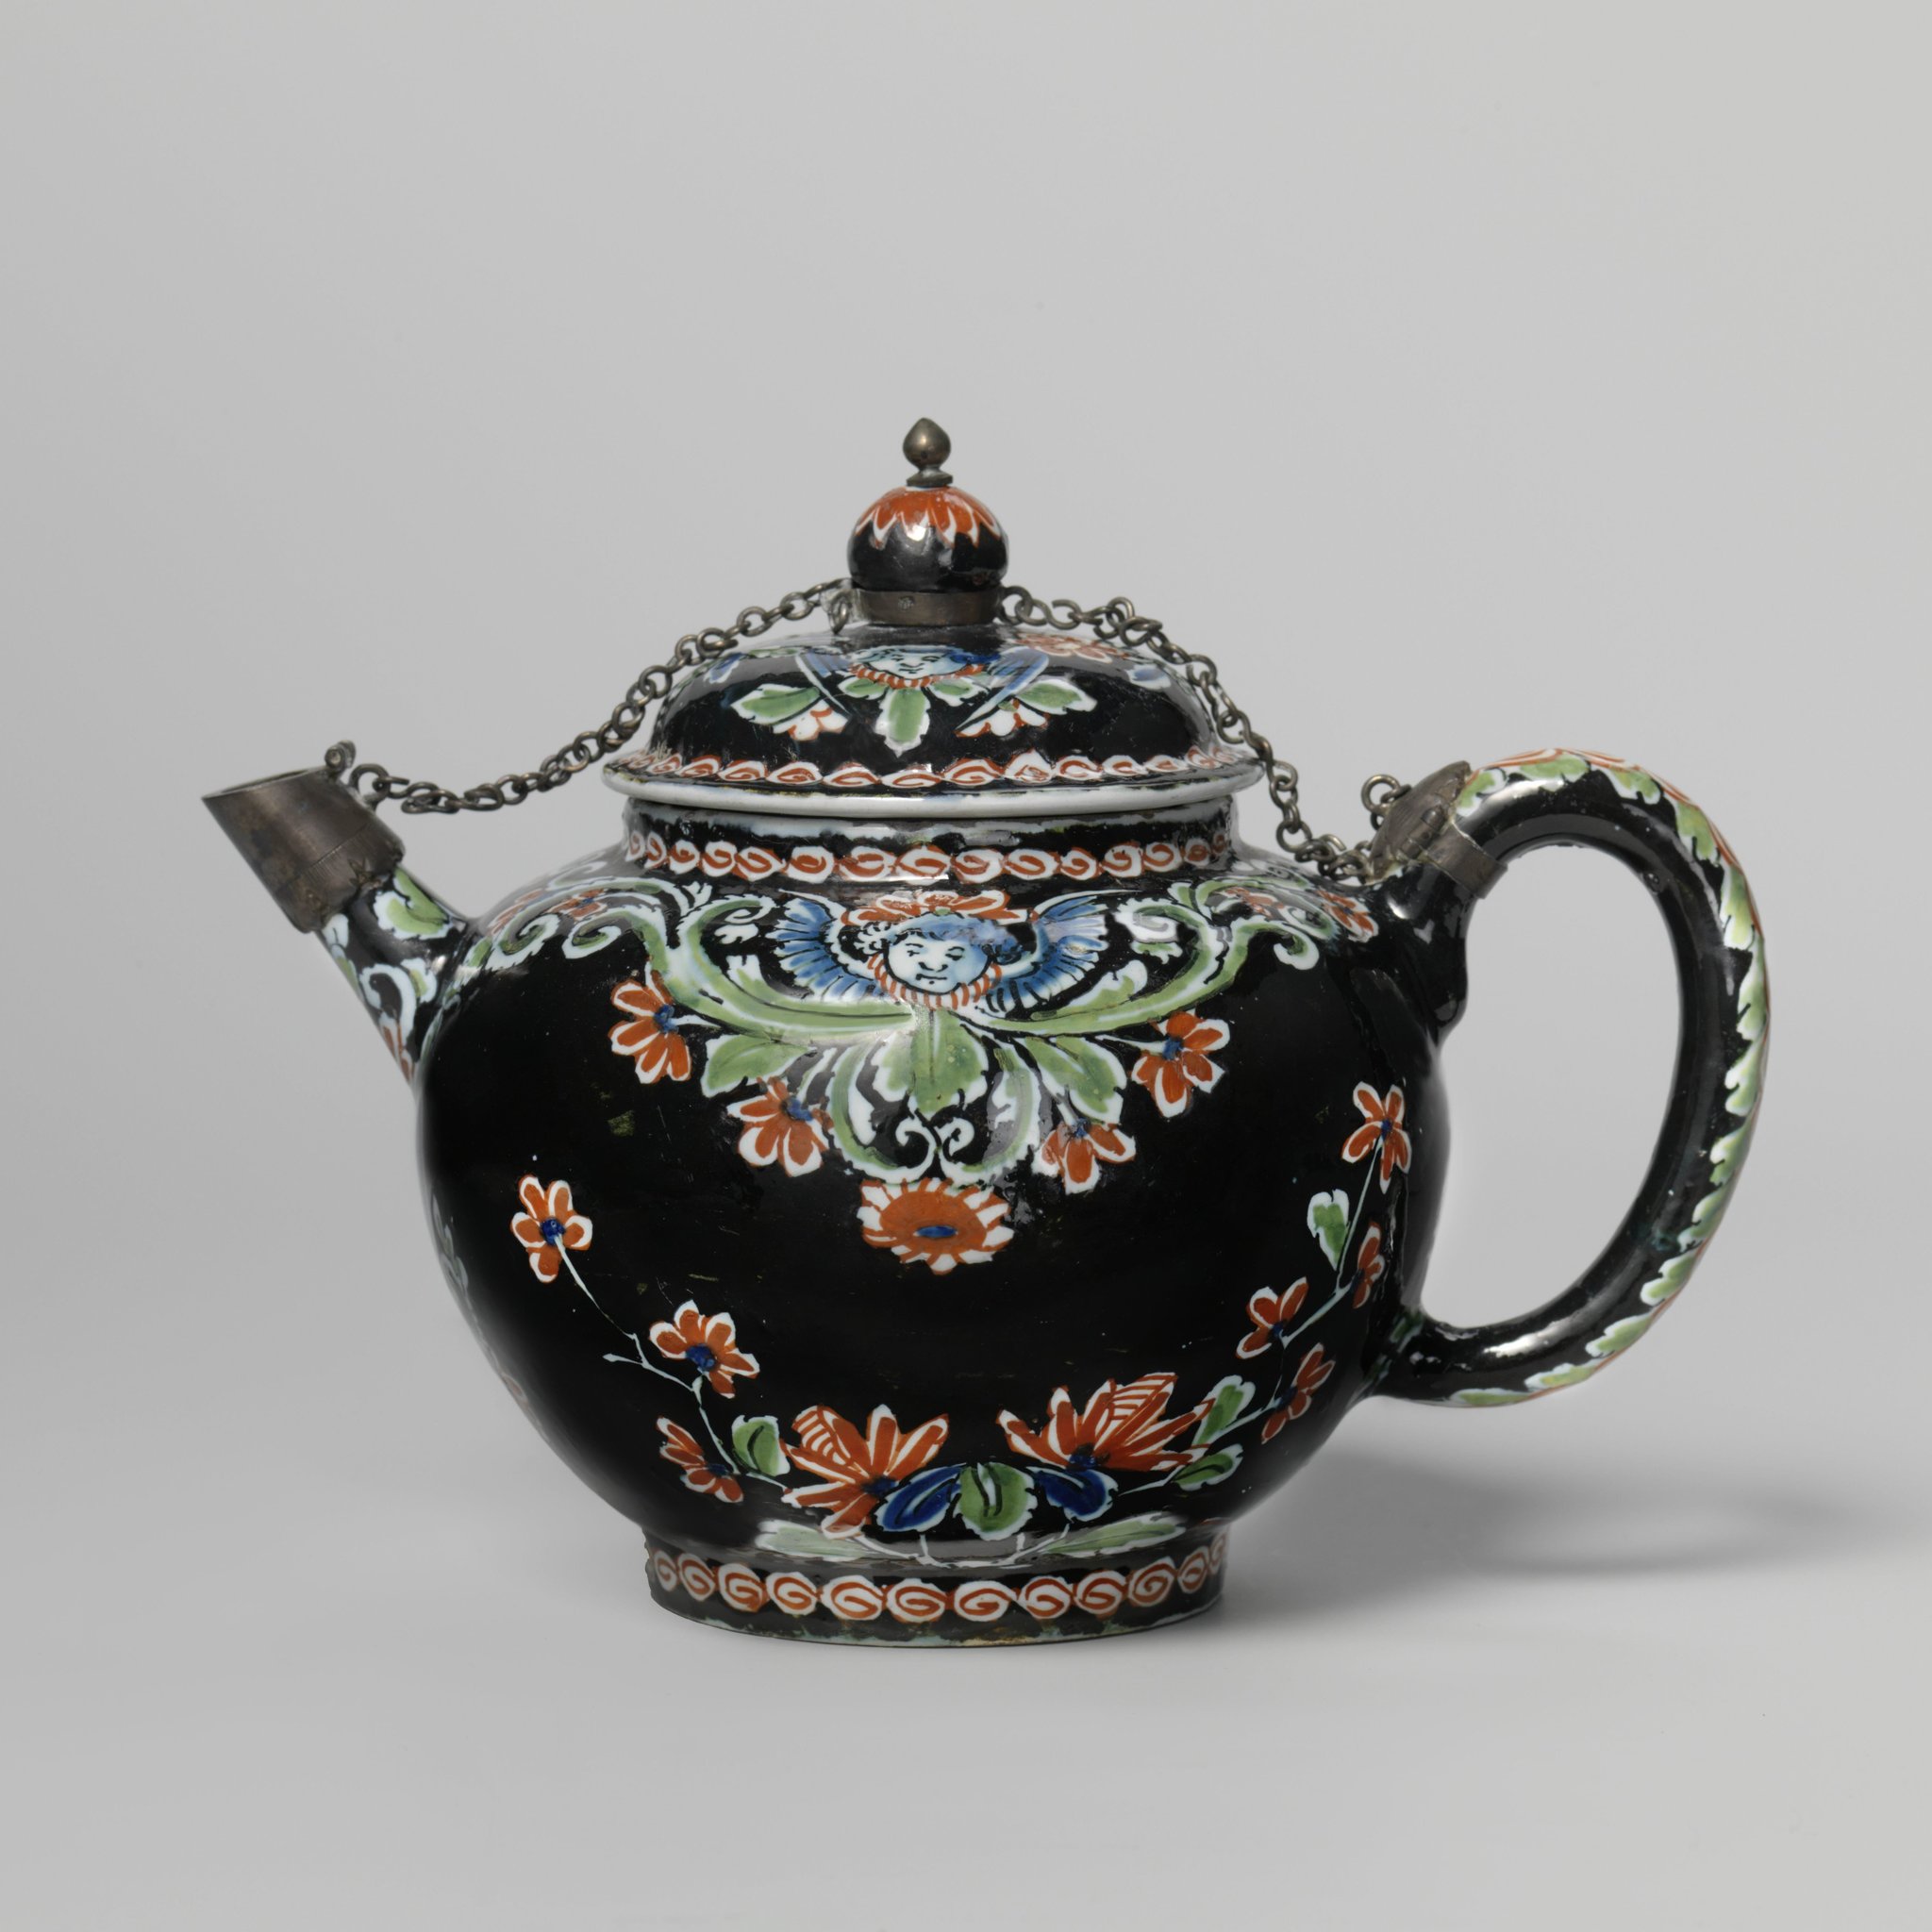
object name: teapot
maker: pieter adriaensz. kocx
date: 1705-1720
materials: earthenware, metal, glaze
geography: delft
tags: ornament derived from plant forms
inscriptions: mark: ‘PAK(ineen) in rood’, collector's mark: ‘collection JF Loudon’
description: Trekpot van faïence. Veelkleurig beschilderd met blad- en bloemdecoraties.